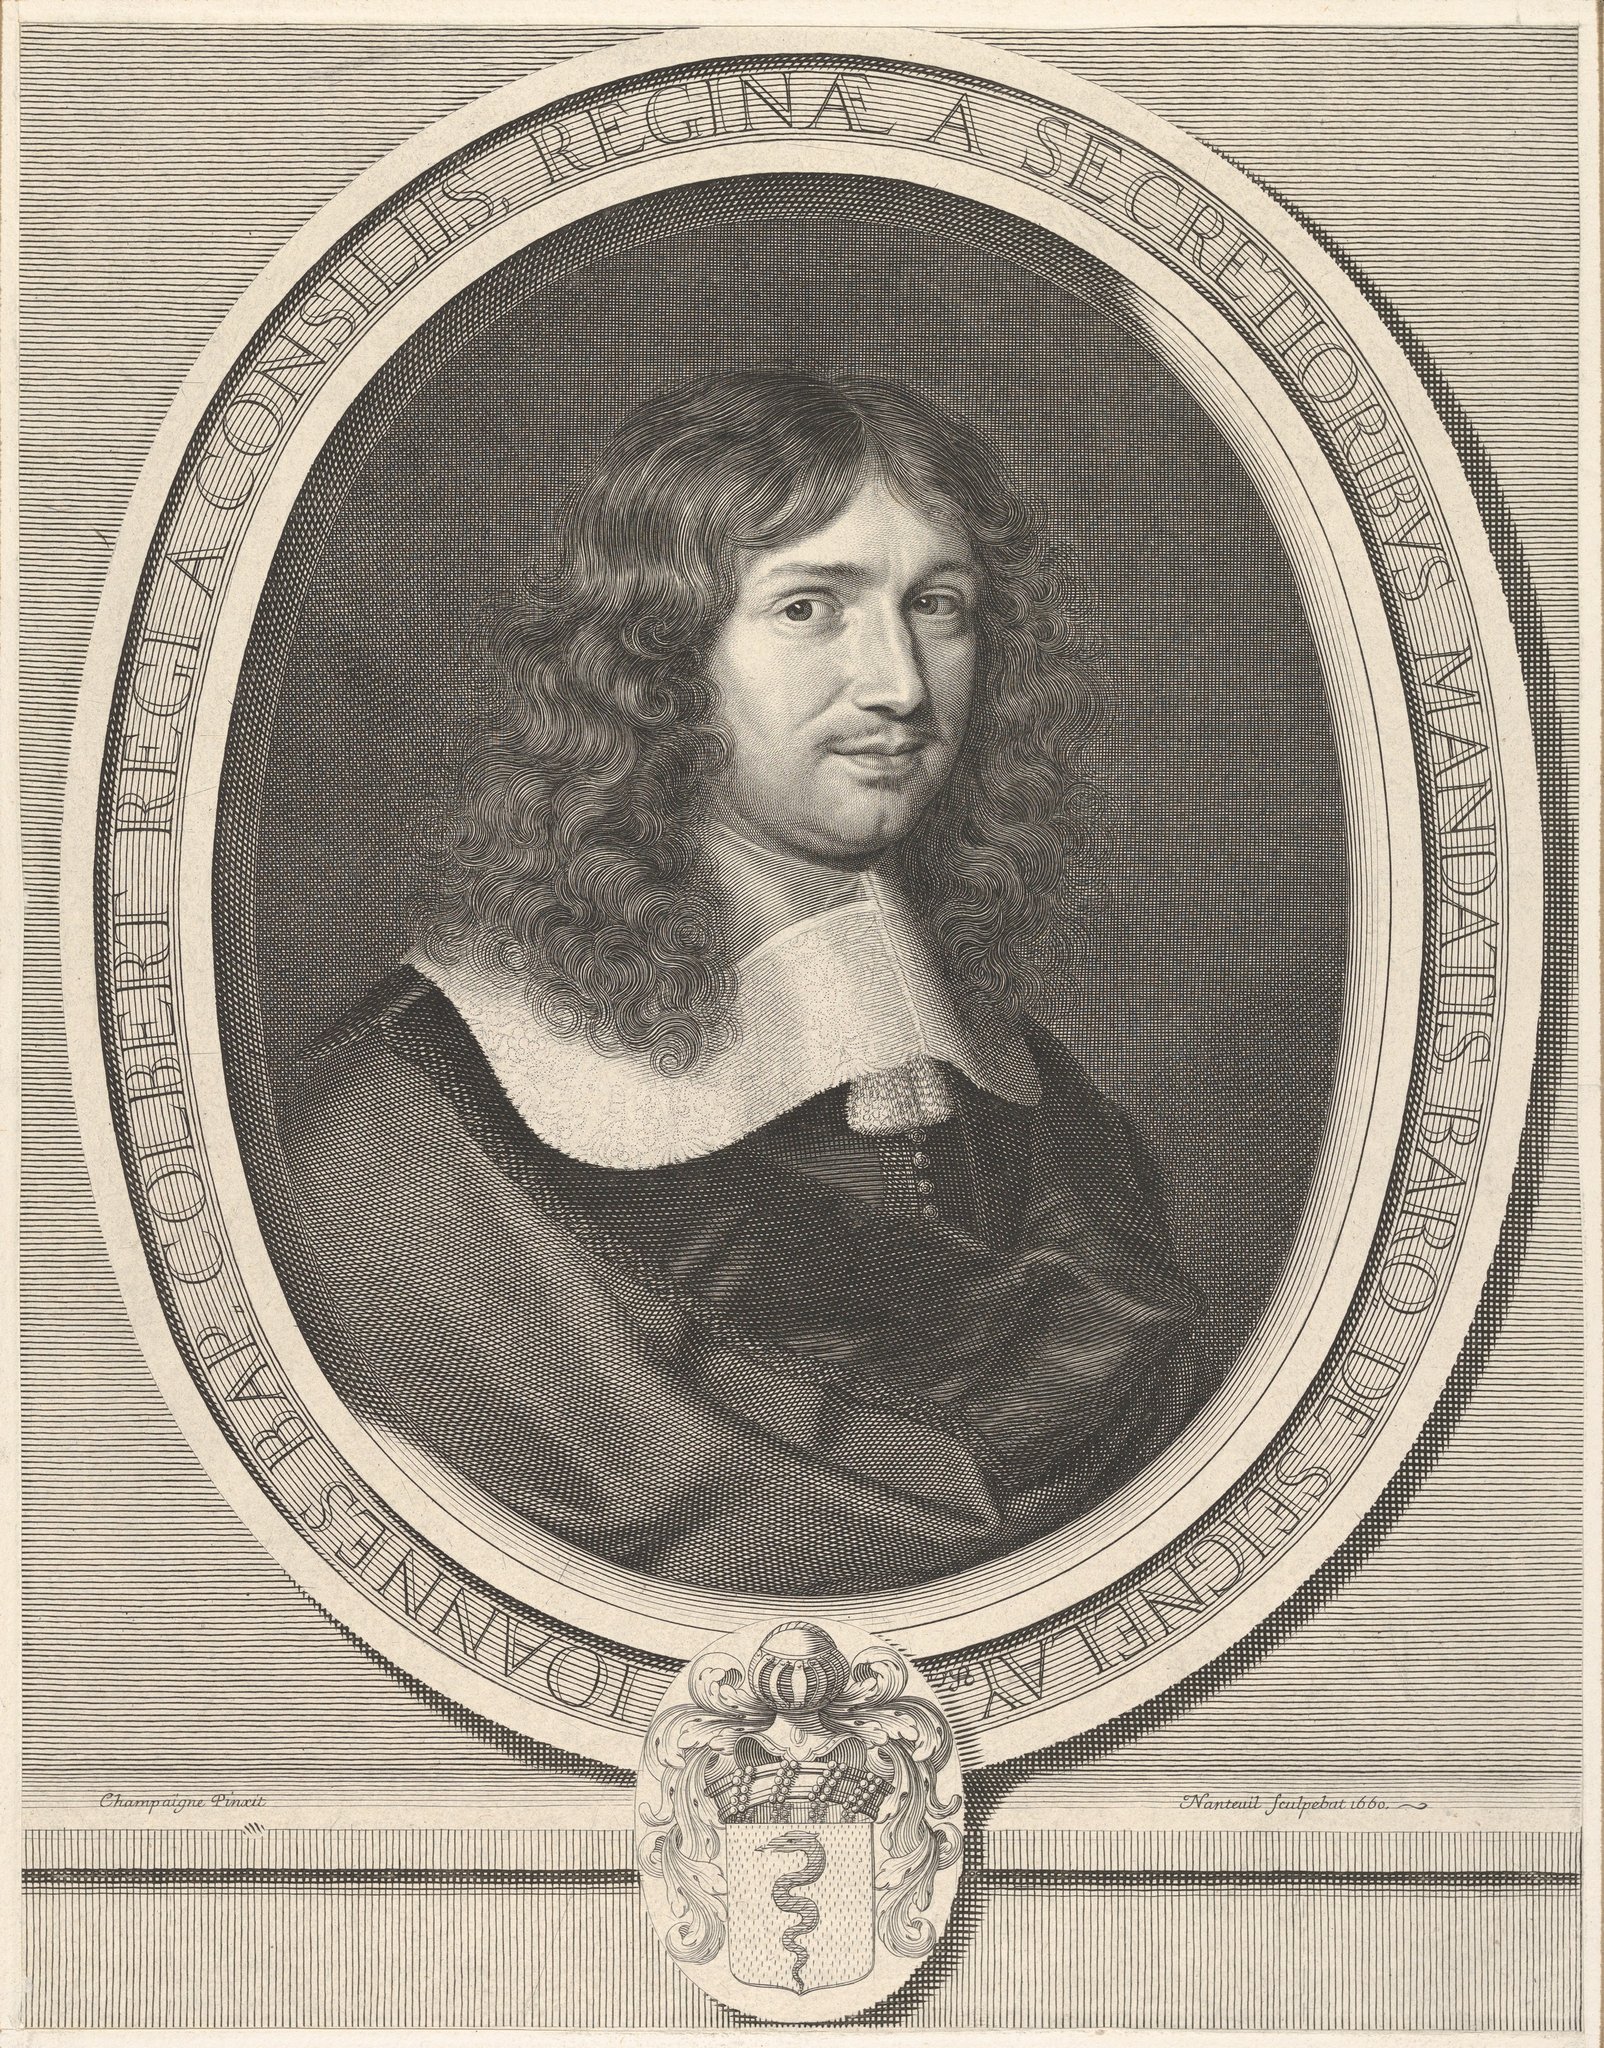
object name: print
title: Jean-Baptiste Colbert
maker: robert nanteuil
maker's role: artist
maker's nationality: french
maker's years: 1623-1678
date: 1660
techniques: engraving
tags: men,portraits